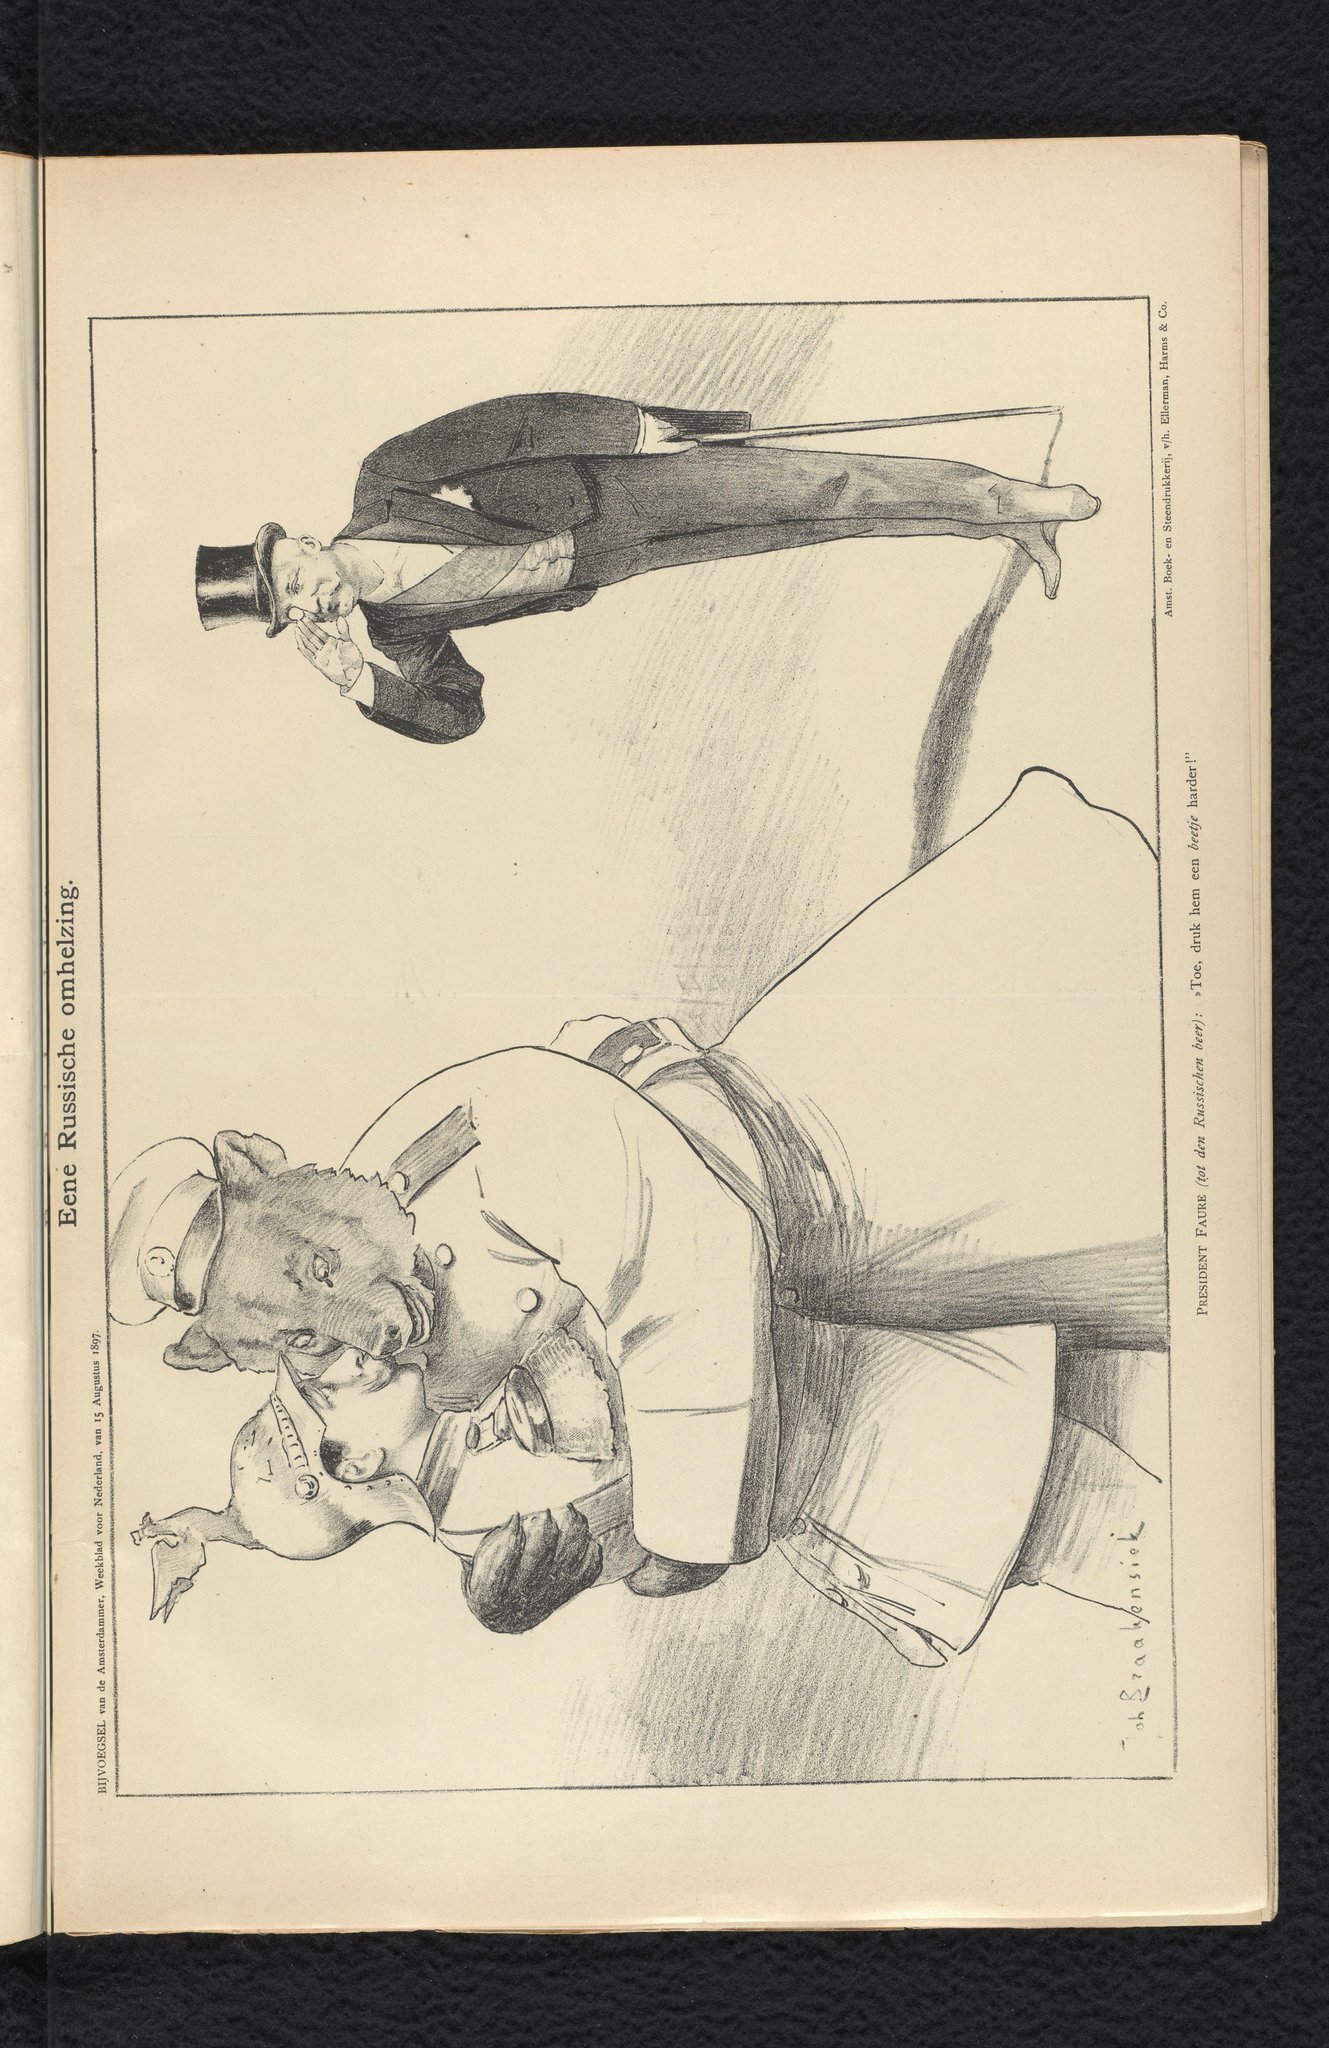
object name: cartoon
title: Eene Russische omhelzing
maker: johan braakensiek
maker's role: draughtsman, print maker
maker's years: 1858-1940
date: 1897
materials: paper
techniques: lithograph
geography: amsterdam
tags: wilhelm ii (keizer van duitsland), personifications of countries, nations, states, districts, etc., embracing each other, kissing, political caricatures and satires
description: De Russische beer omhelst de Duitse keizer Wilhelm II, de Franse president Faure moedigt de beer aan harder te drukken.